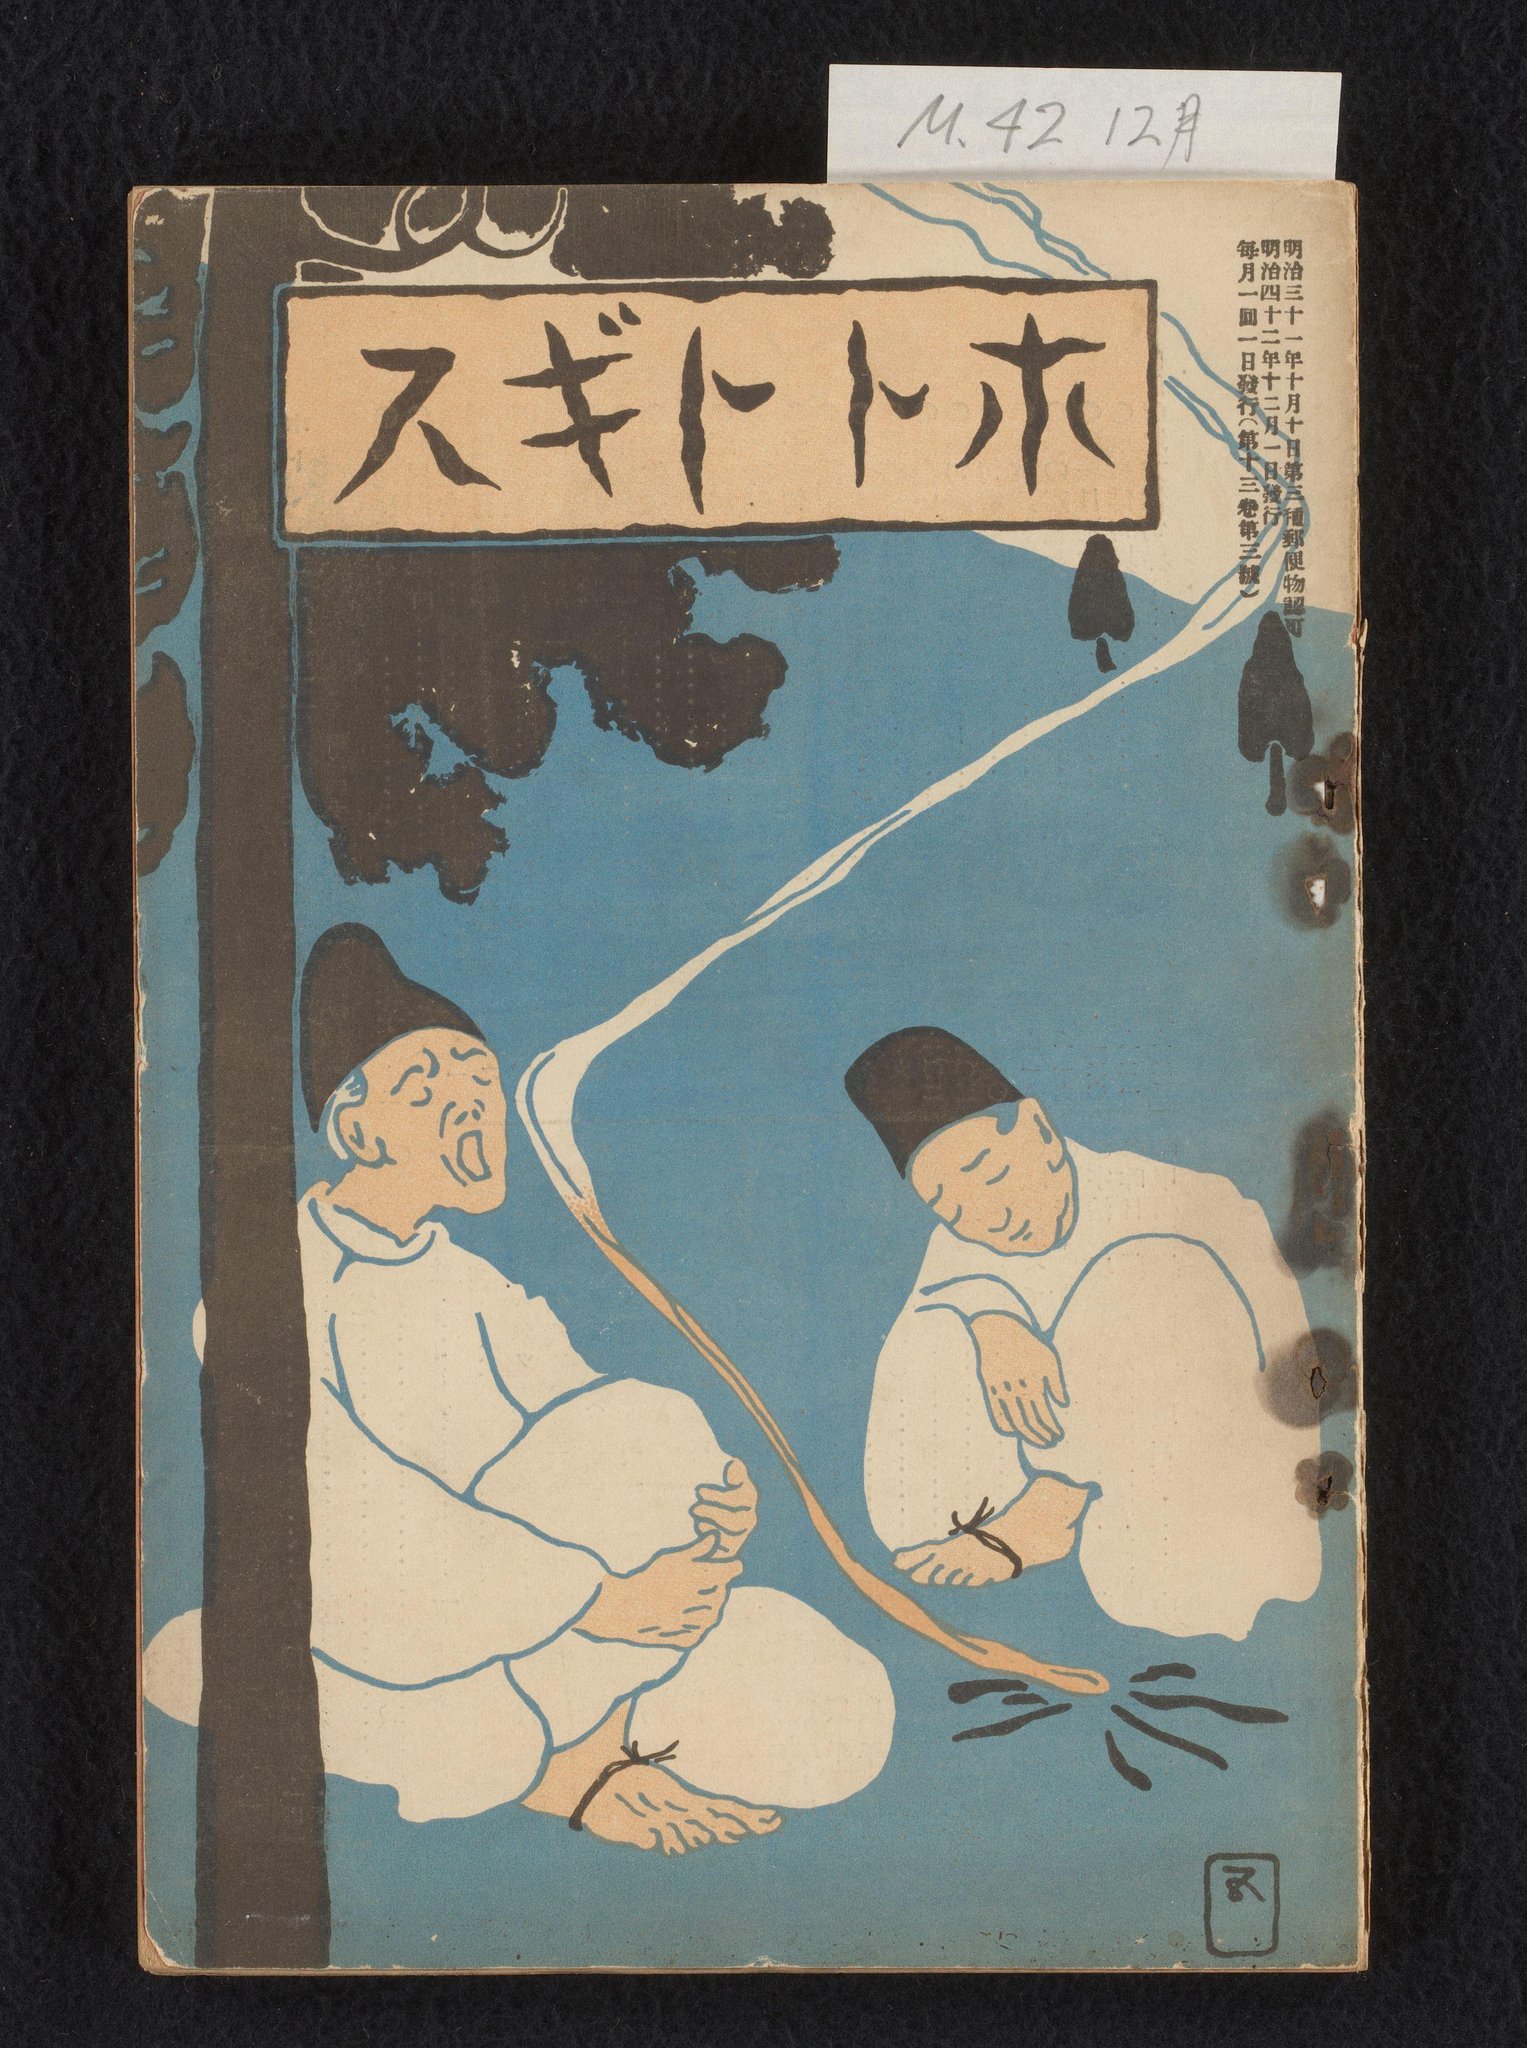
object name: magazine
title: December 1909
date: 1909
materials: paper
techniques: woodcut, letterpress printing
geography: japan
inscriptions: date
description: Ontwerp titelplaat: Hashiguchi Goyô. Overige illustraties: Shimomura Izan (1), Okamoto Gesson (6), Miyazaki Yohei (5), Ishii Hakutei (4), Kinoshita Shigeru (2), Kikuchi Samanosuke (1) en Ijûin Hiroshi (1). Ontwerp achterkant illustratie: Nakamura Fusetsu.